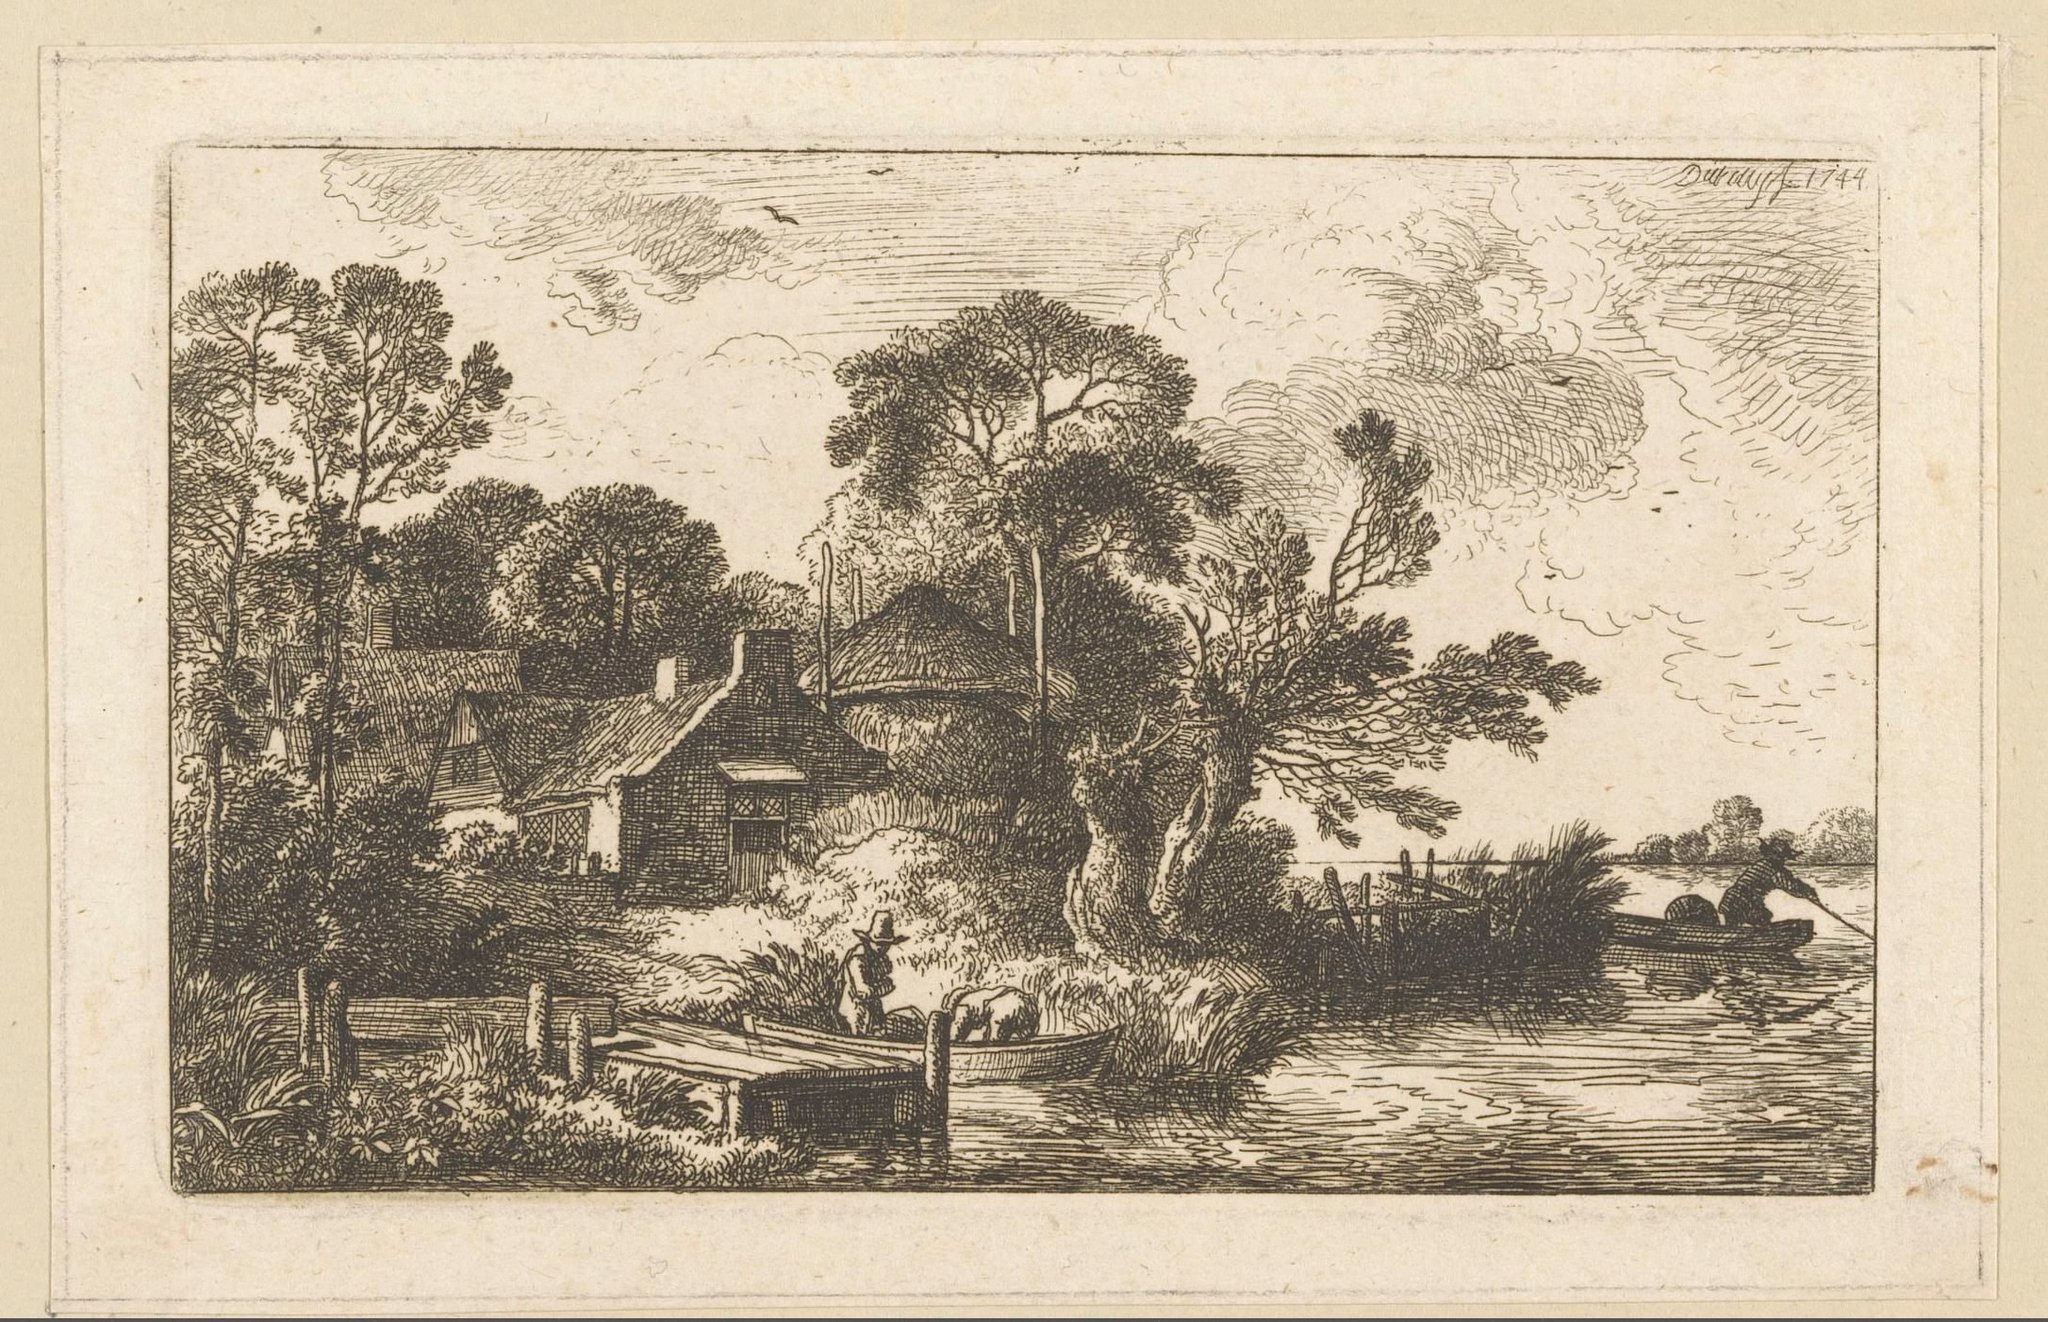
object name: print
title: Boerderij met hooiberg aan het water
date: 1744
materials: paper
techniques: etching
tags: city-view, and landscape with man-made constructions, hay-stack, farm (building), rowing-boat, canoe, etc. (+ view ~ vehicle, ship, etc.)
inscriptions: collector's mark: Lugt 240